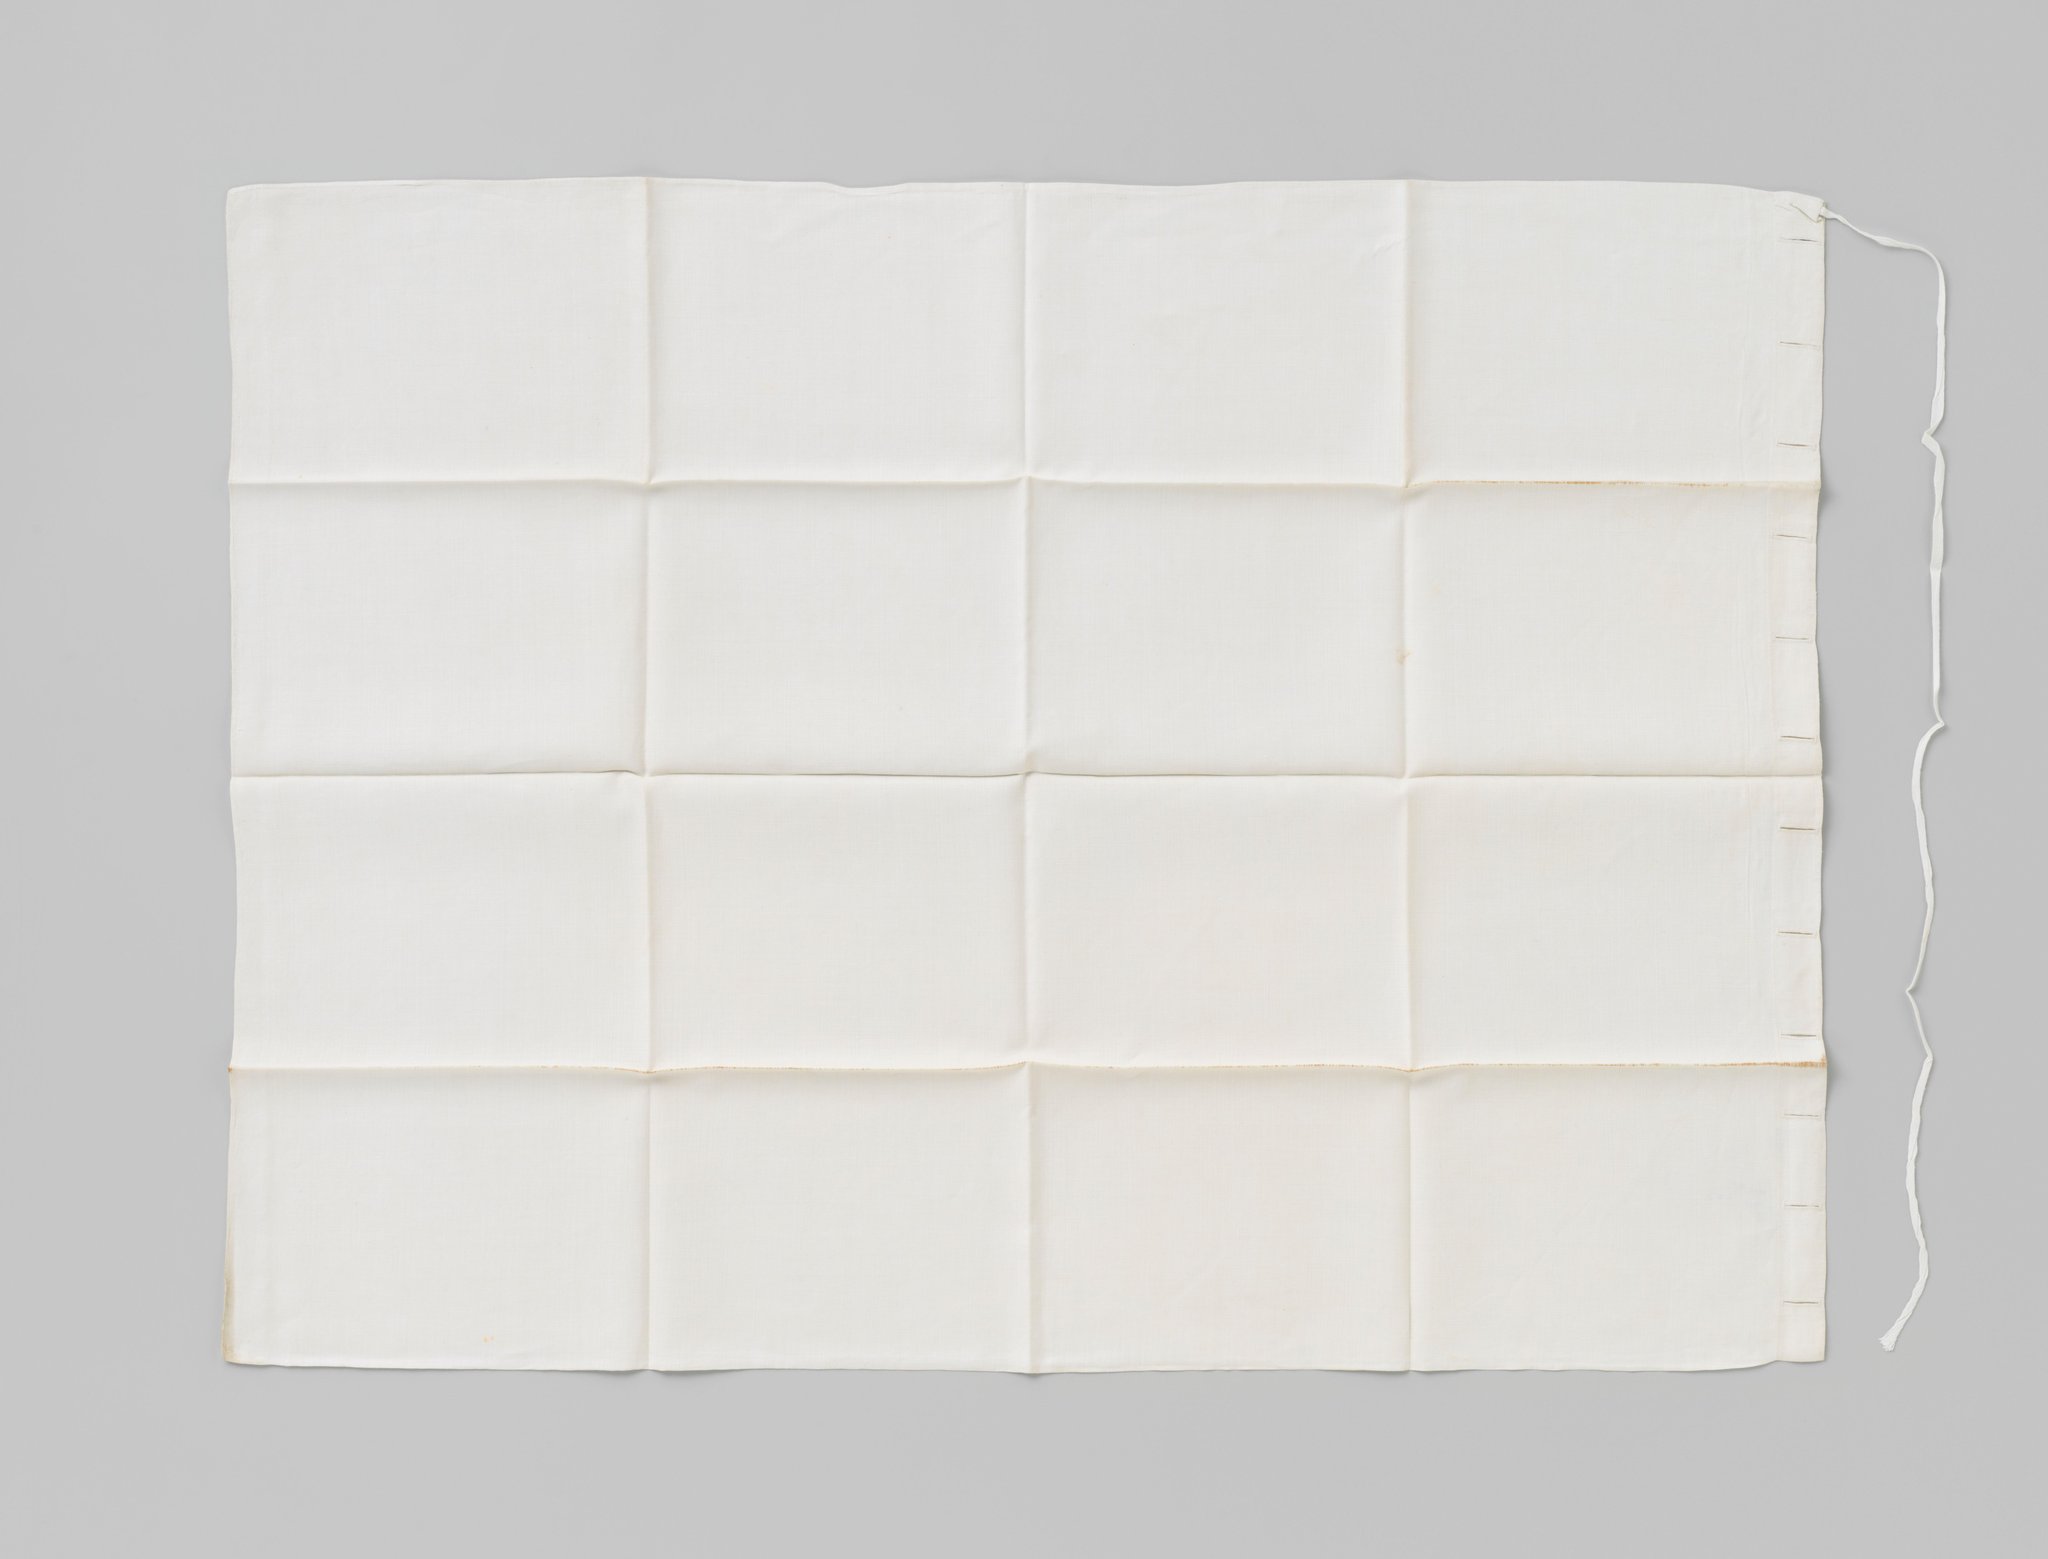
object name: sloop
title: Sloop van wit linnen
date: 1825-1875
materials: linen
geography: northern netherlands